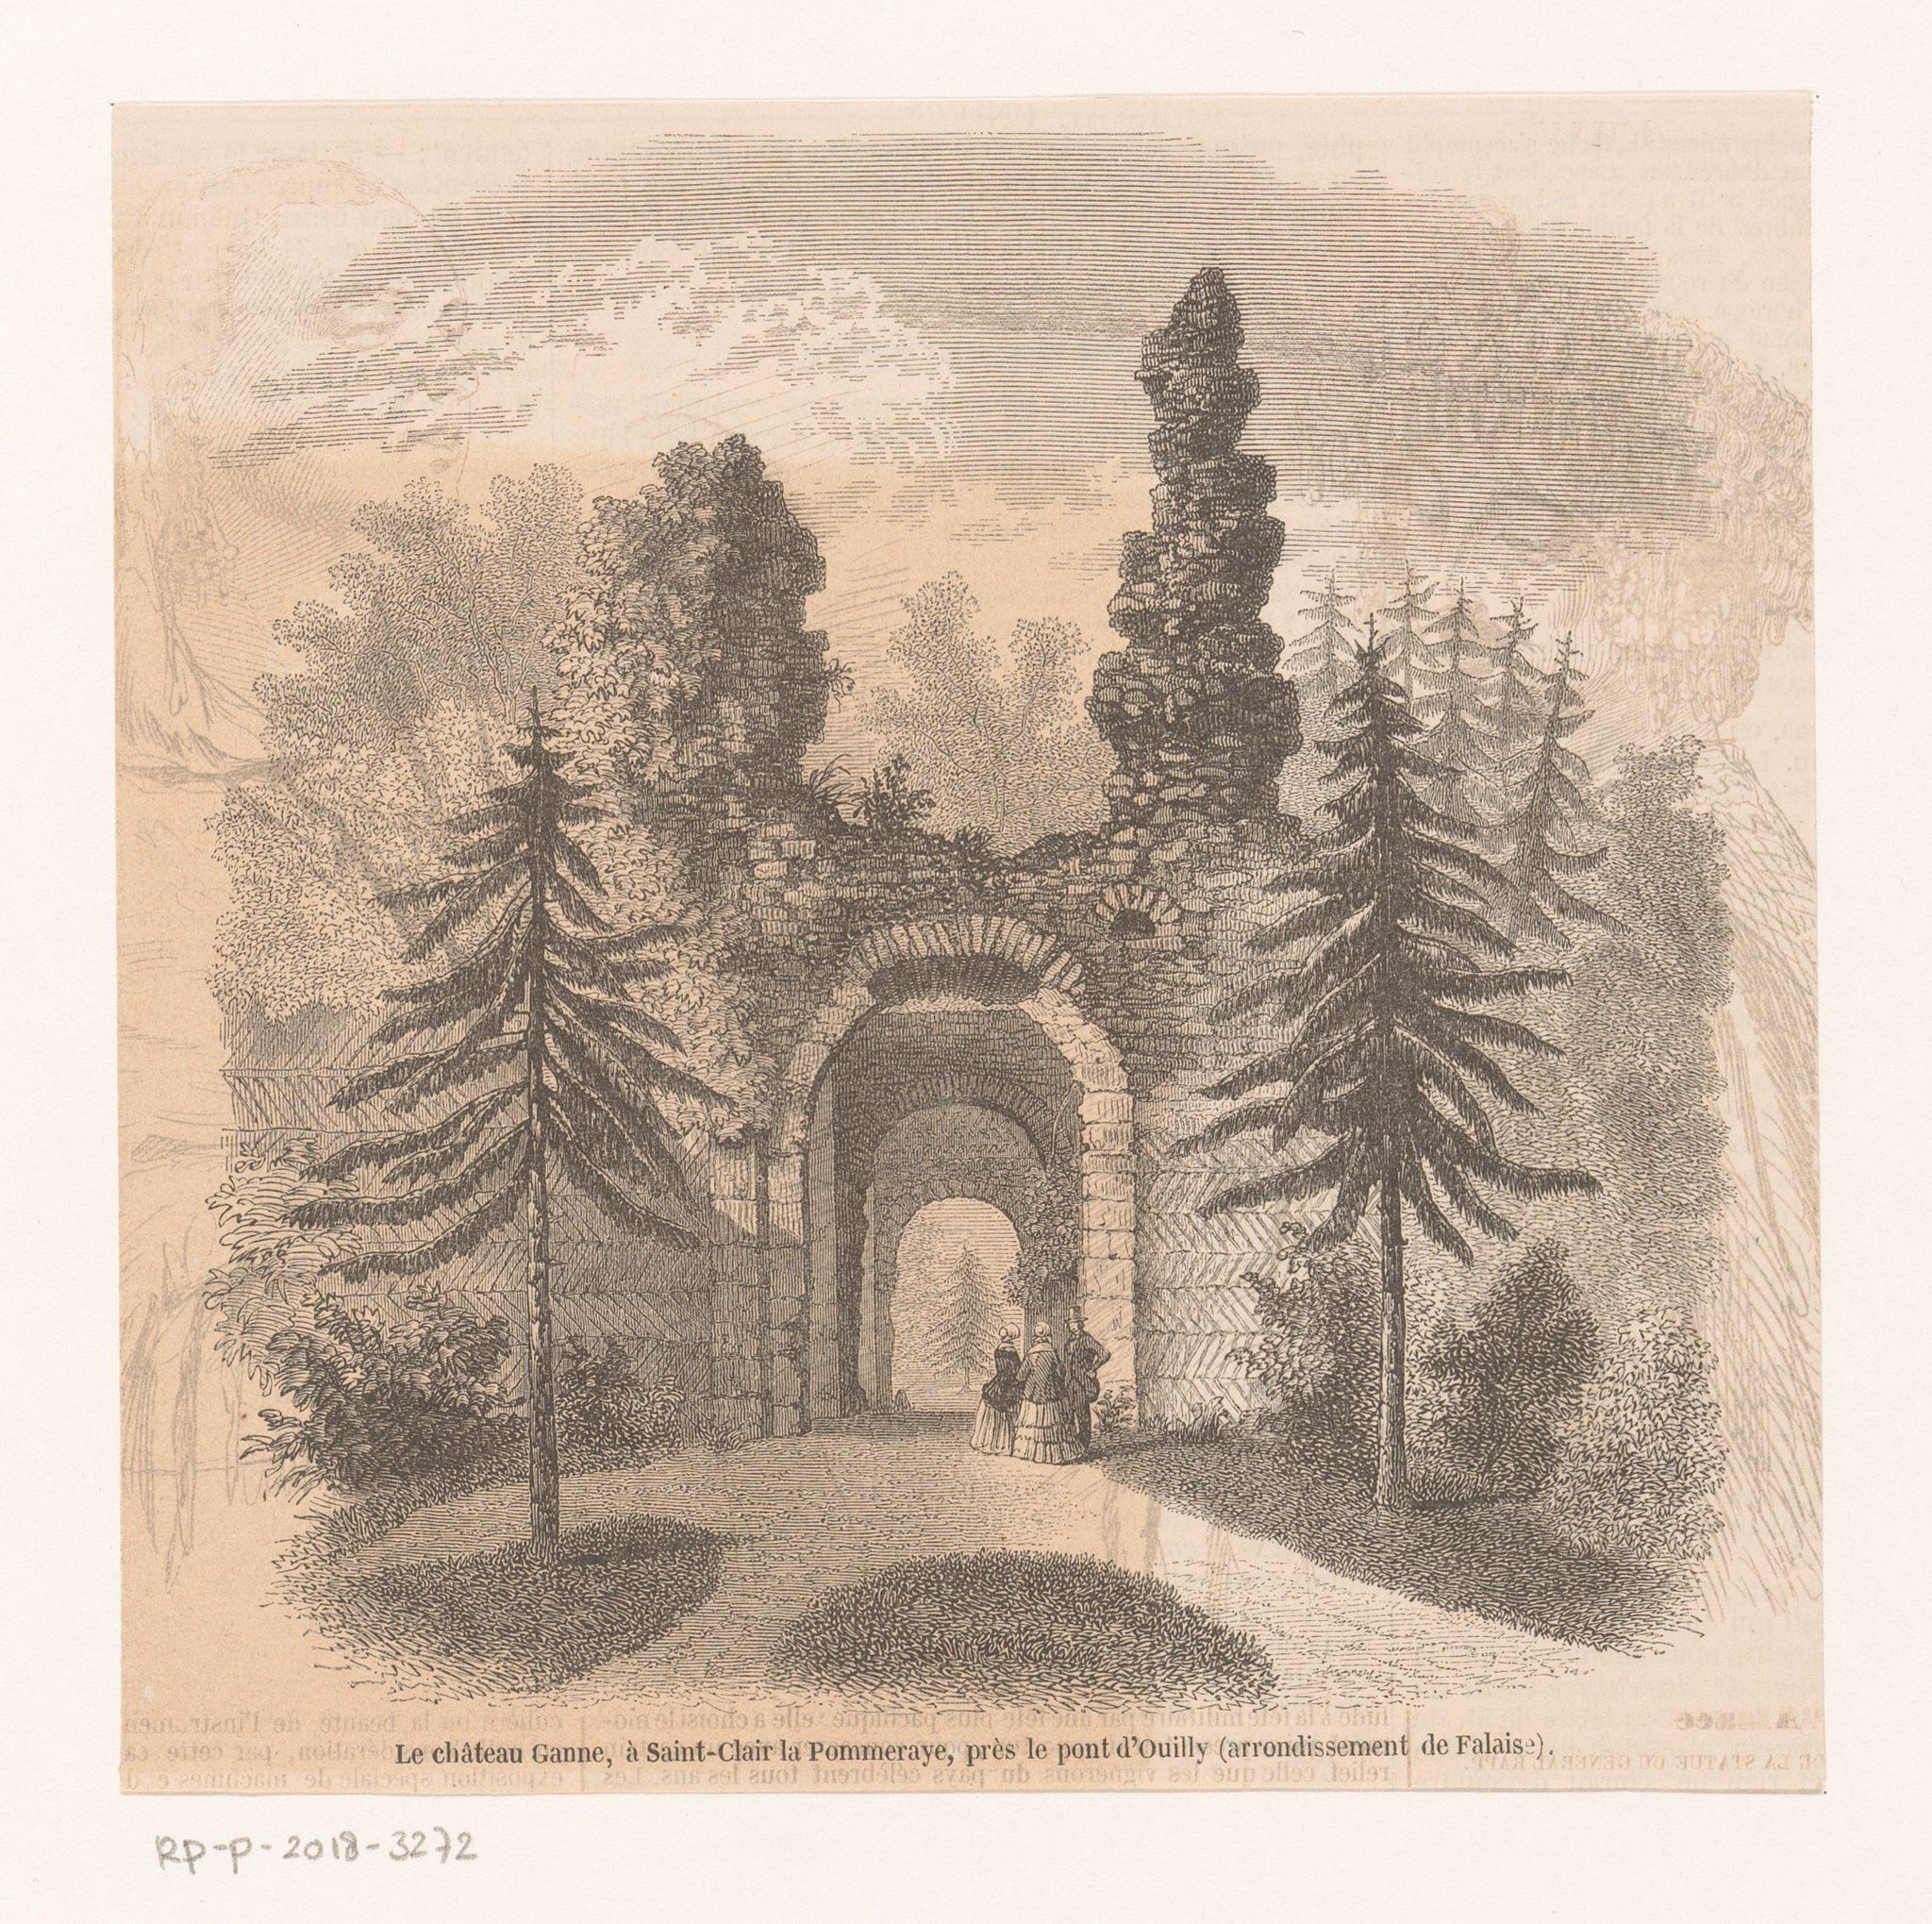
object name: print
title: Le château Ganne, à Saint-Clair la Pommeraye, près le pont d'ouilly (arrondissement de Falaise)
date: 1856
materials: paper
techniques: letterpress printing, engraving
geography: paris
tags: landscape with tower or castle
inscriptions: inscription: ‘L'Illustration 26 sept. 1856’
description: Prent uit: L'Illustration, Journal Universel, 26 september 1856.